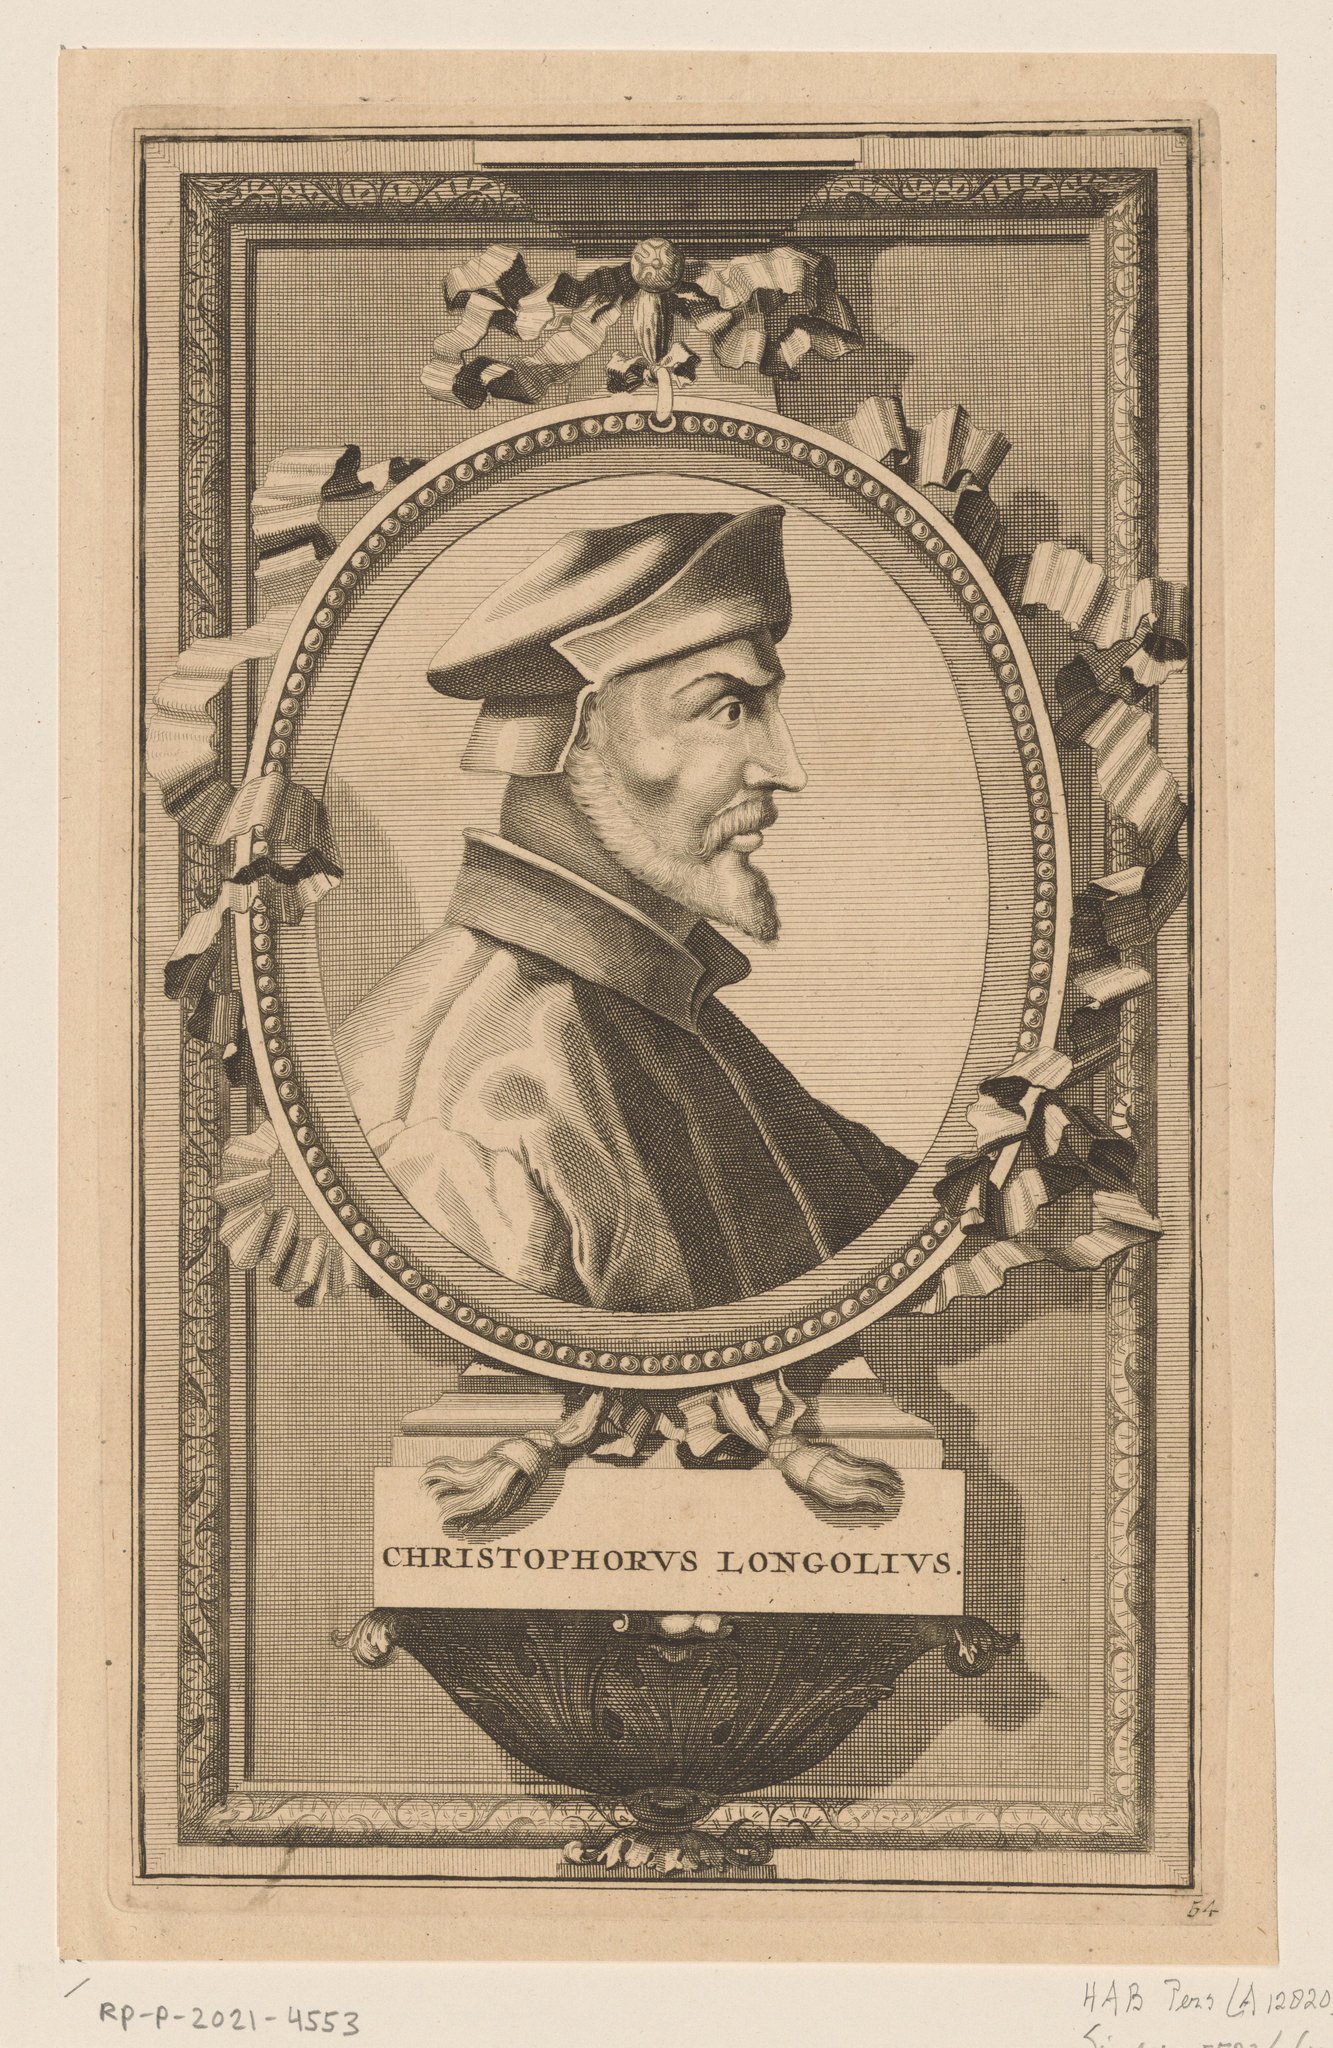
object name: print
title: Portret van Christophe de Longueil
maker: Anonymous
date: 1700-1799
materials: paper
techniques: engraving, etching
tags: mechelen, ornament ~ medallion, historical persons